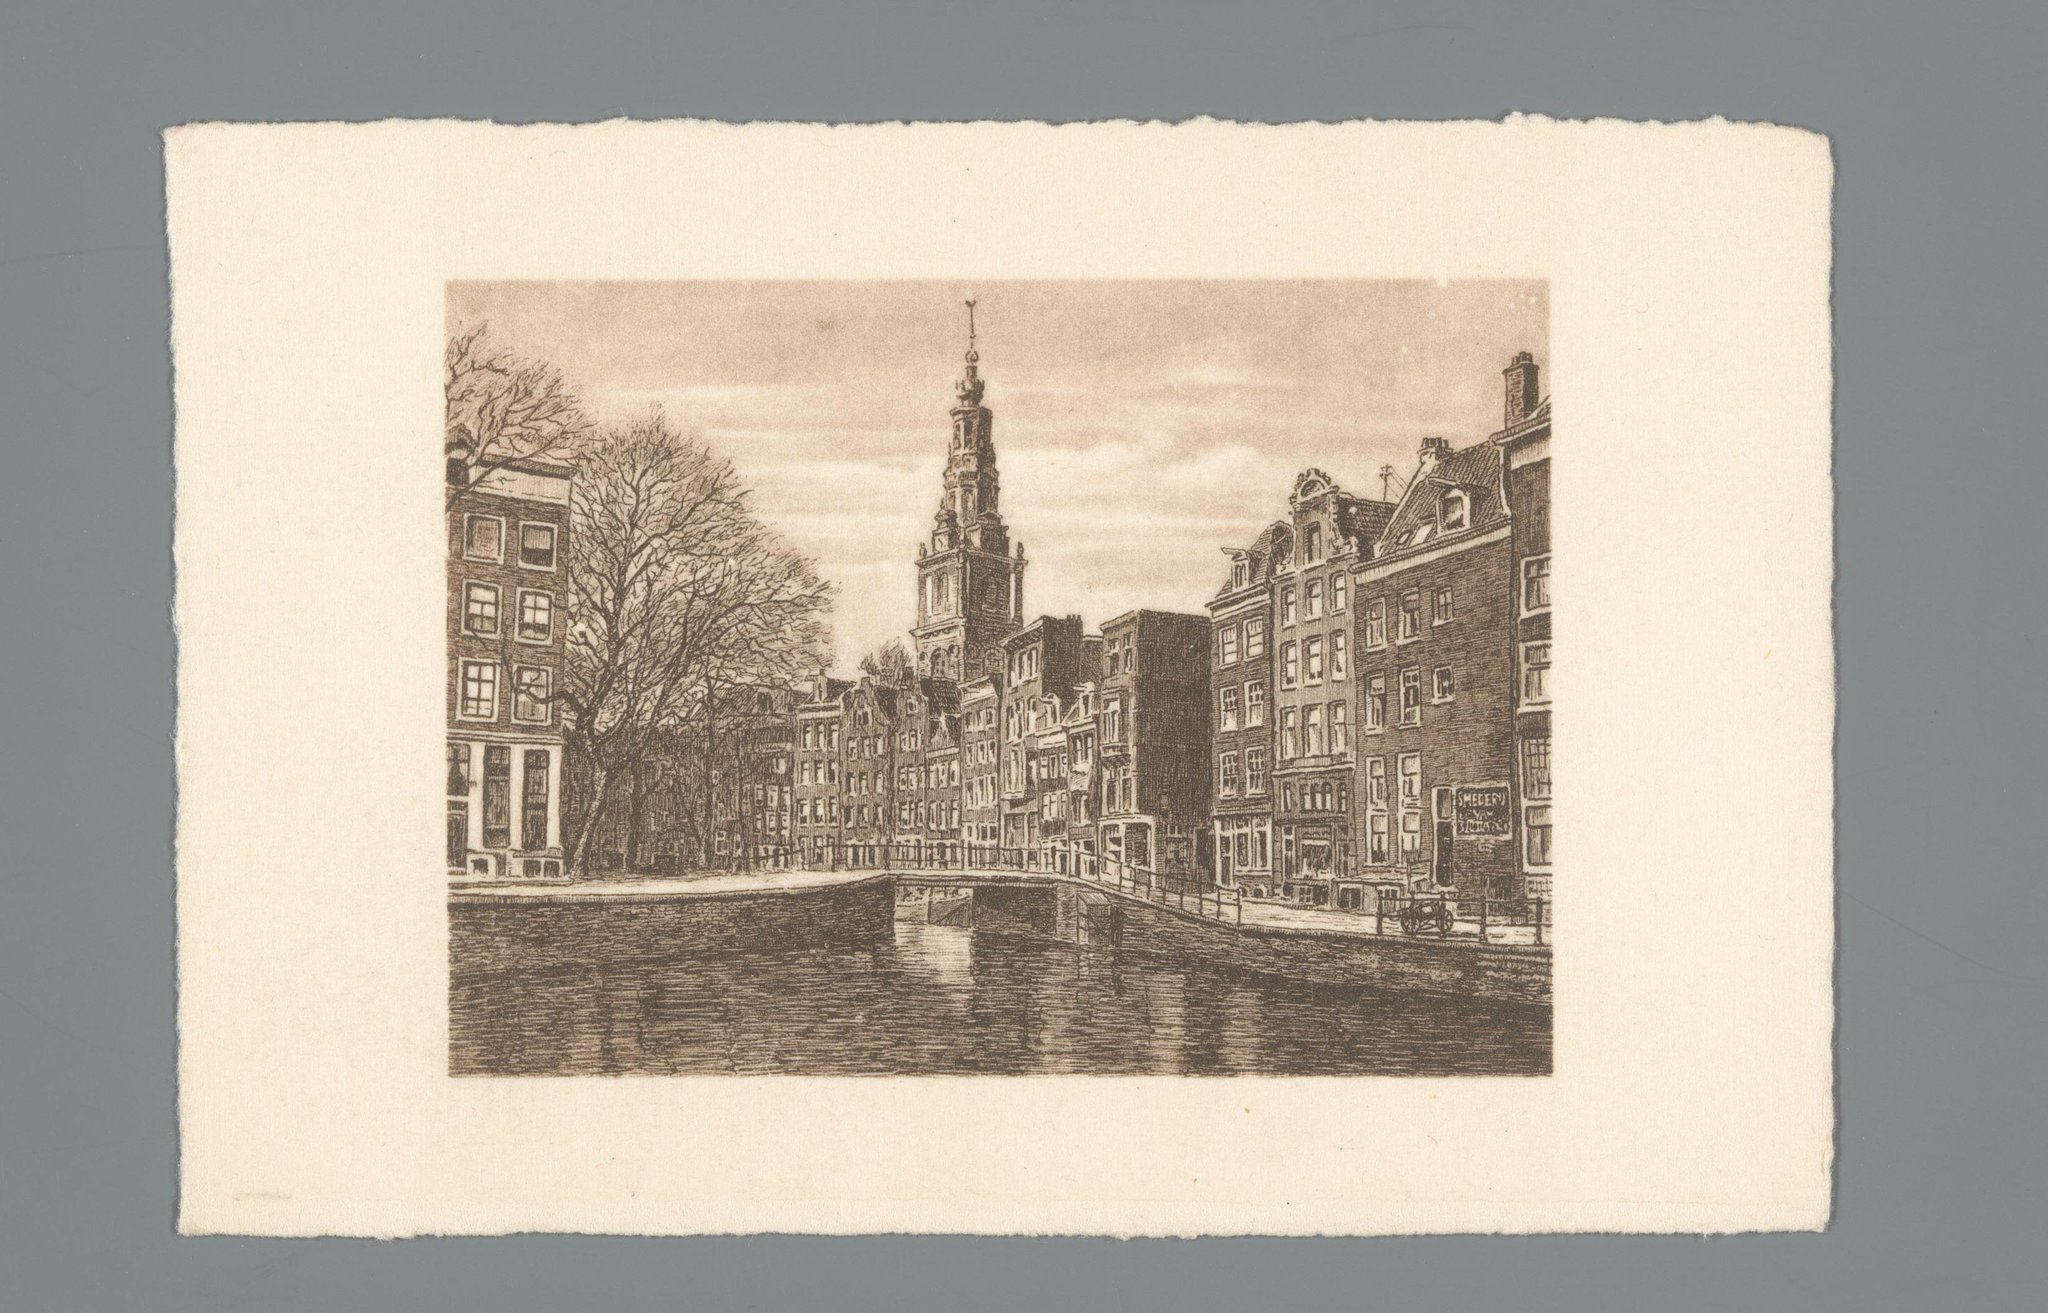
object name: print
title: Gezicht op de Raamgracht en Zuiderkerktoren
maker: Anonymous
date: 1800-1900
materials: paper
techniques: lithograph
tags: city-view, and landscape with man-made constructions, canals, waters (in city)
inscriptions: inscription: ‘Raamgracht met Zuiderkerktoren Amsterdam’